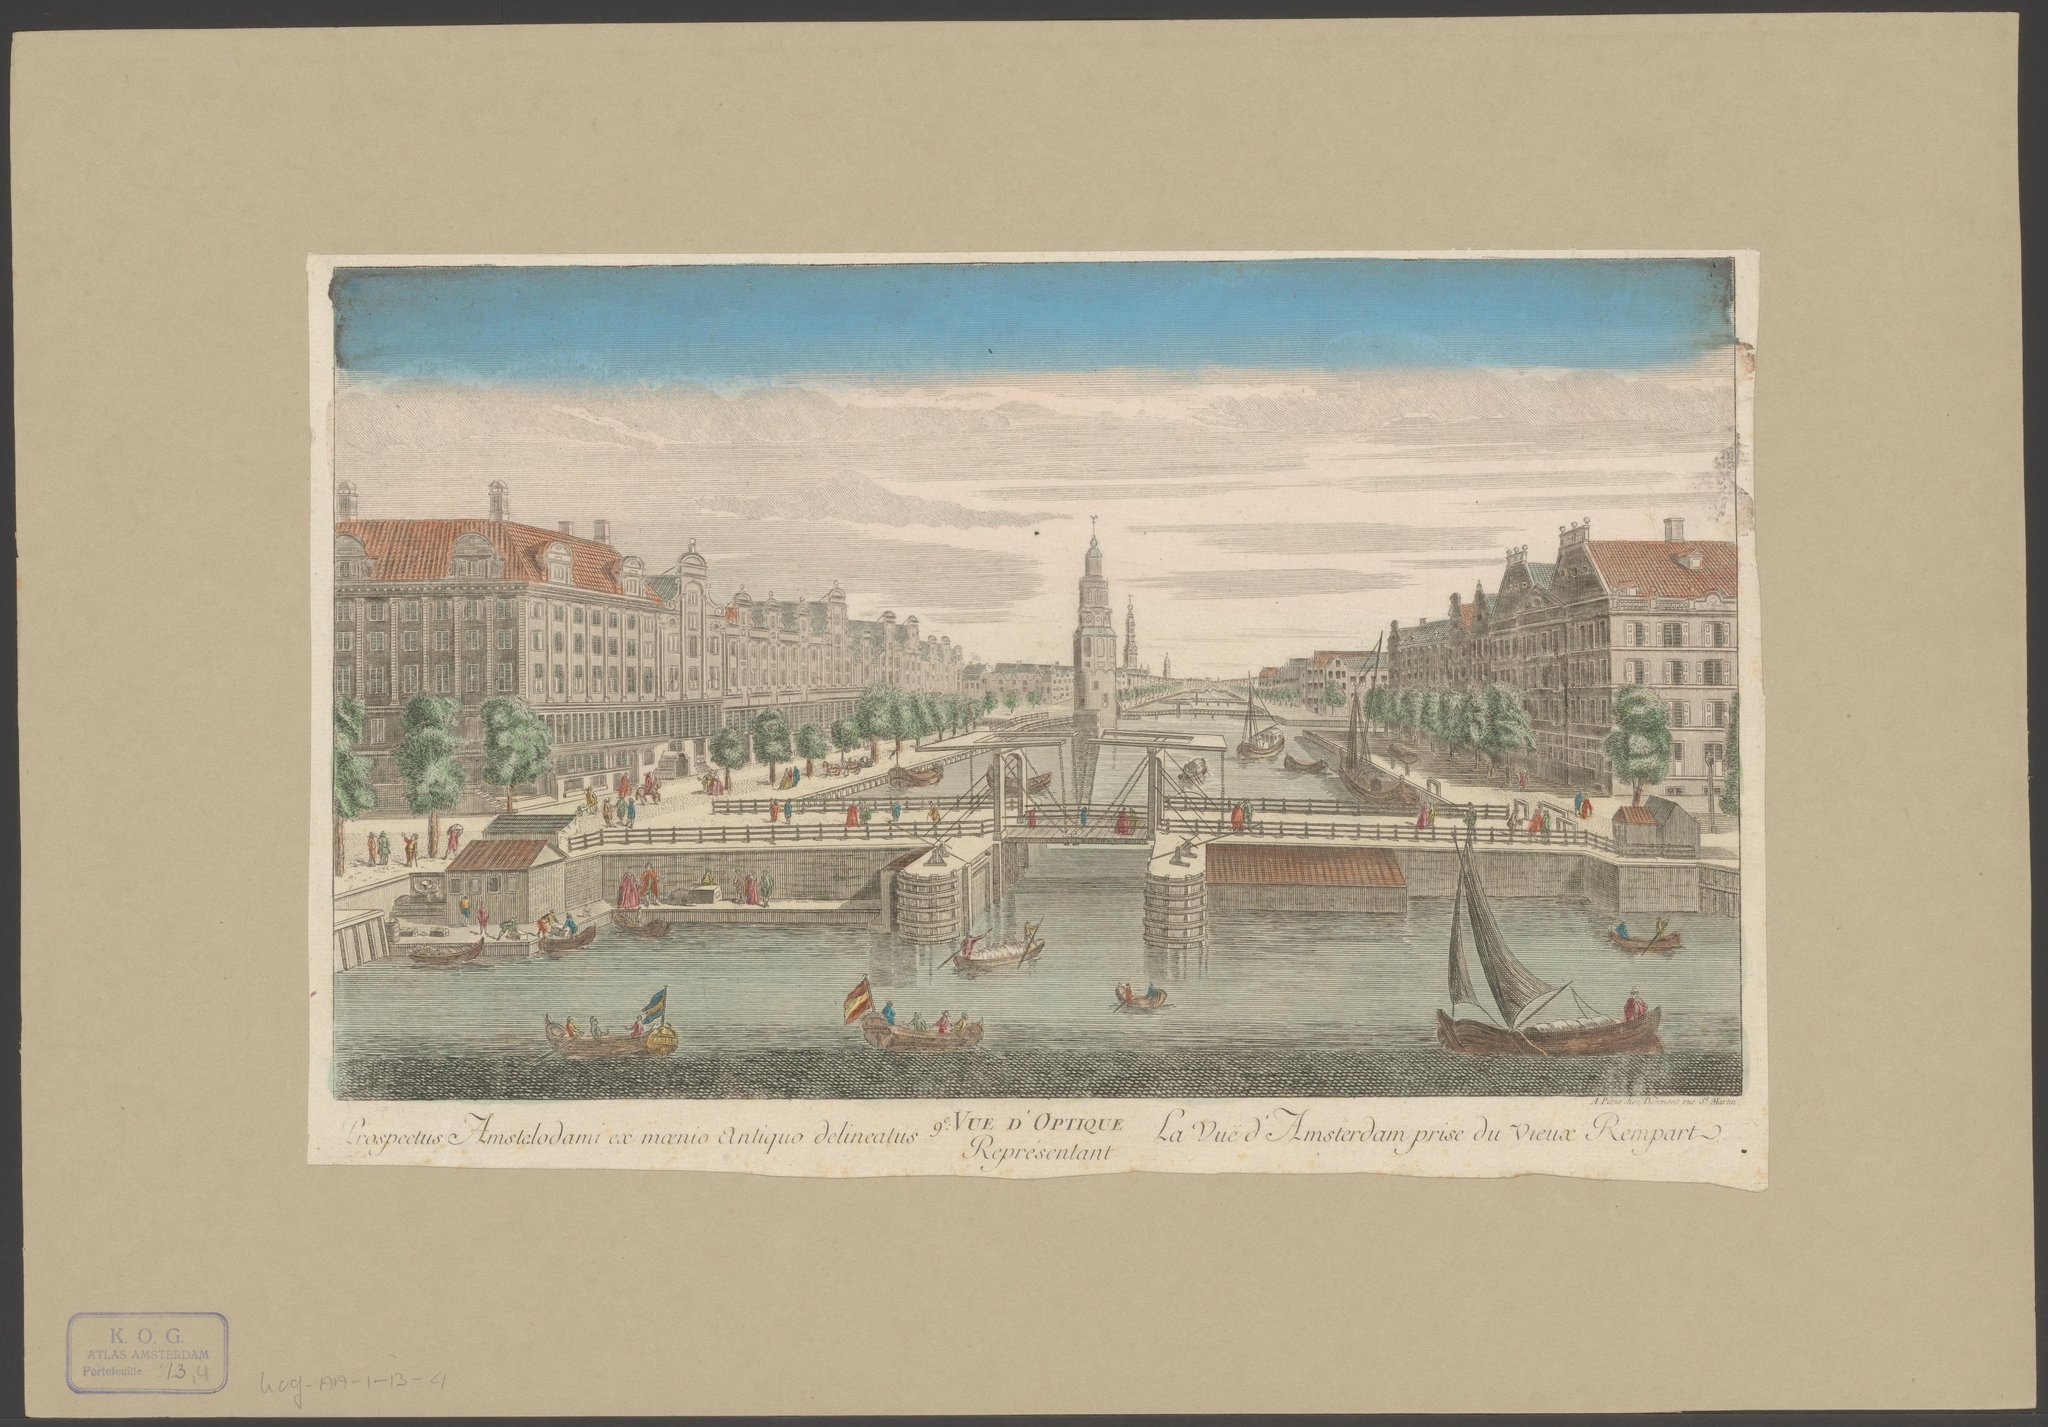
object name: print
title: Gezicht op Amsterdam vanaf de Oude Schans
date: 1745-1775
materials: paper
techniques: etching, hand coloring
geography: paris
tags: sailing-ship, sailing-boat, tower, clock tower ~ monumental adornment, city-view in general; 'veduta', river, bridge in city across river, canal, etc., boat propelled by man or animal, amsterdam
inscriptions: collector's mark: ‘13,4’ Lugt 1641b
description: Onderwerpsrubriek binnen de Atlas Amsterdam: Oude Schans, Schoutensteeg, Singel (Korte), Singel.